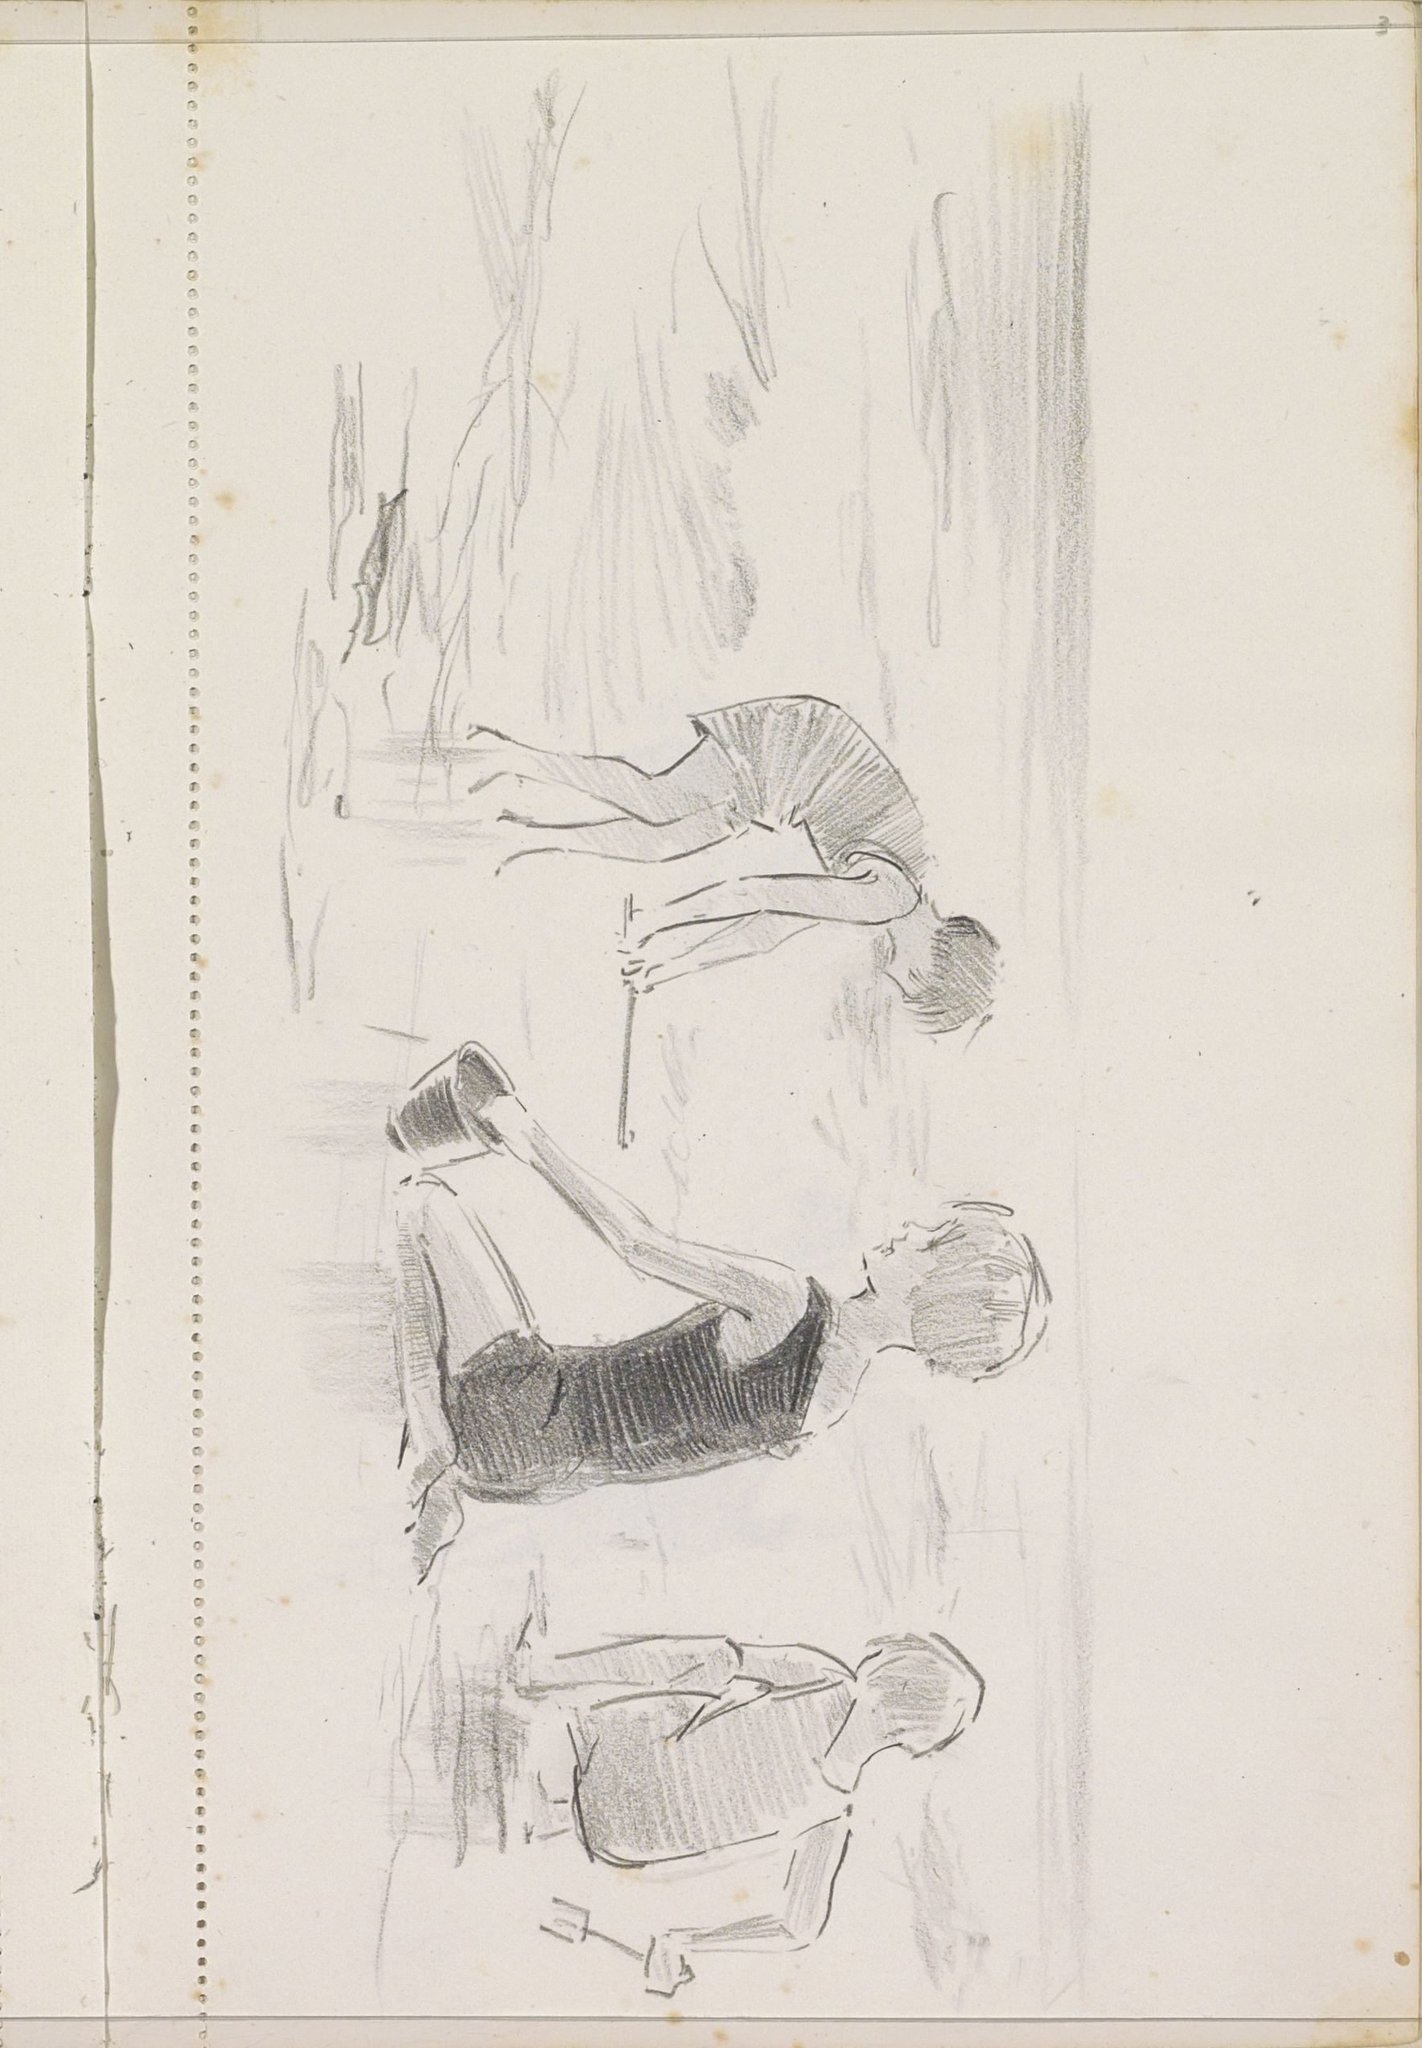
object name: sketchbook leaf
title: Drie spelende kinderen aan de vloedlijn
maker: otto verhagen (i)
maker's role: draughtsman, print maker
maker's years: 1885-1951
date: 1928-1930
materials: chalk, paper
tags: children's games and plays, beach (+ landscape with figures, staffage)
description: De kinderen spelen met een emmer en schep. Pagina 3 uit een schetsboek met 51 bladen.